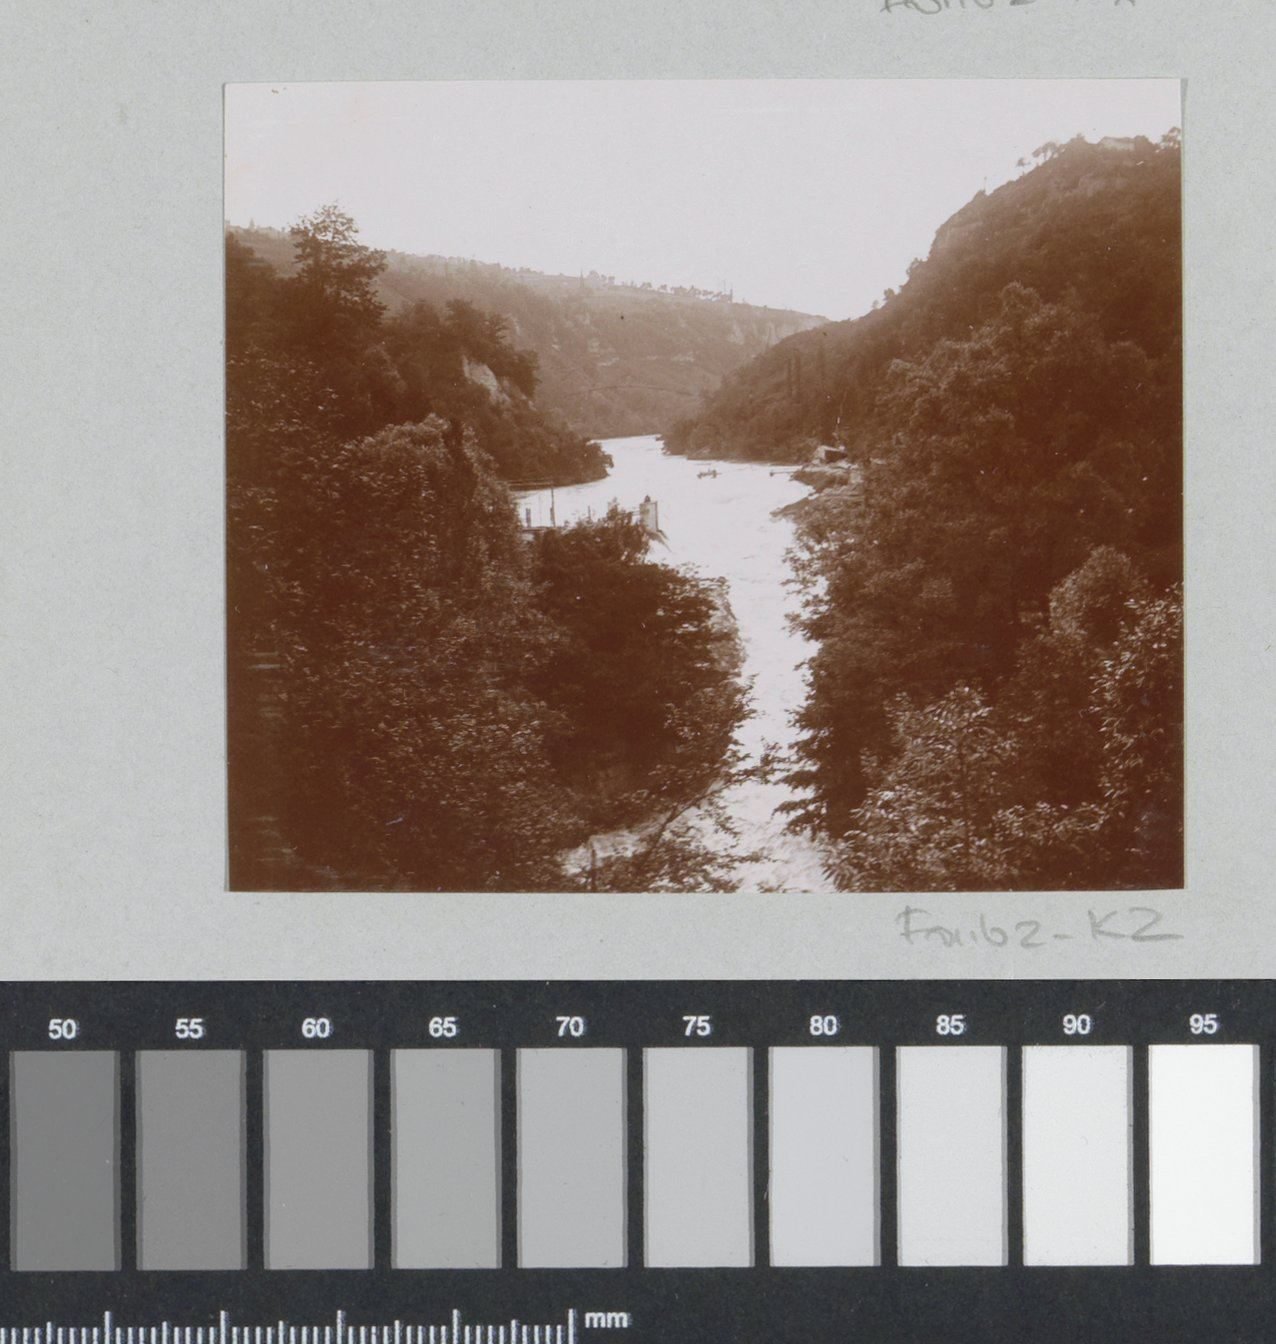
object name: photograph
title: Berglandschap met een beek, vermoedelijk in Frankrijk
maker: Anonymous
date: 1905-1910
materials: paper, photographic support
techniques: gelatin silver print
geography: france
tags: brook, mountains, france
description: Onderdeel van Fotoalbum van een Franse amateurfotograaf met bezienswaardigheden in Frankrijk, Zwitserland en Italië.